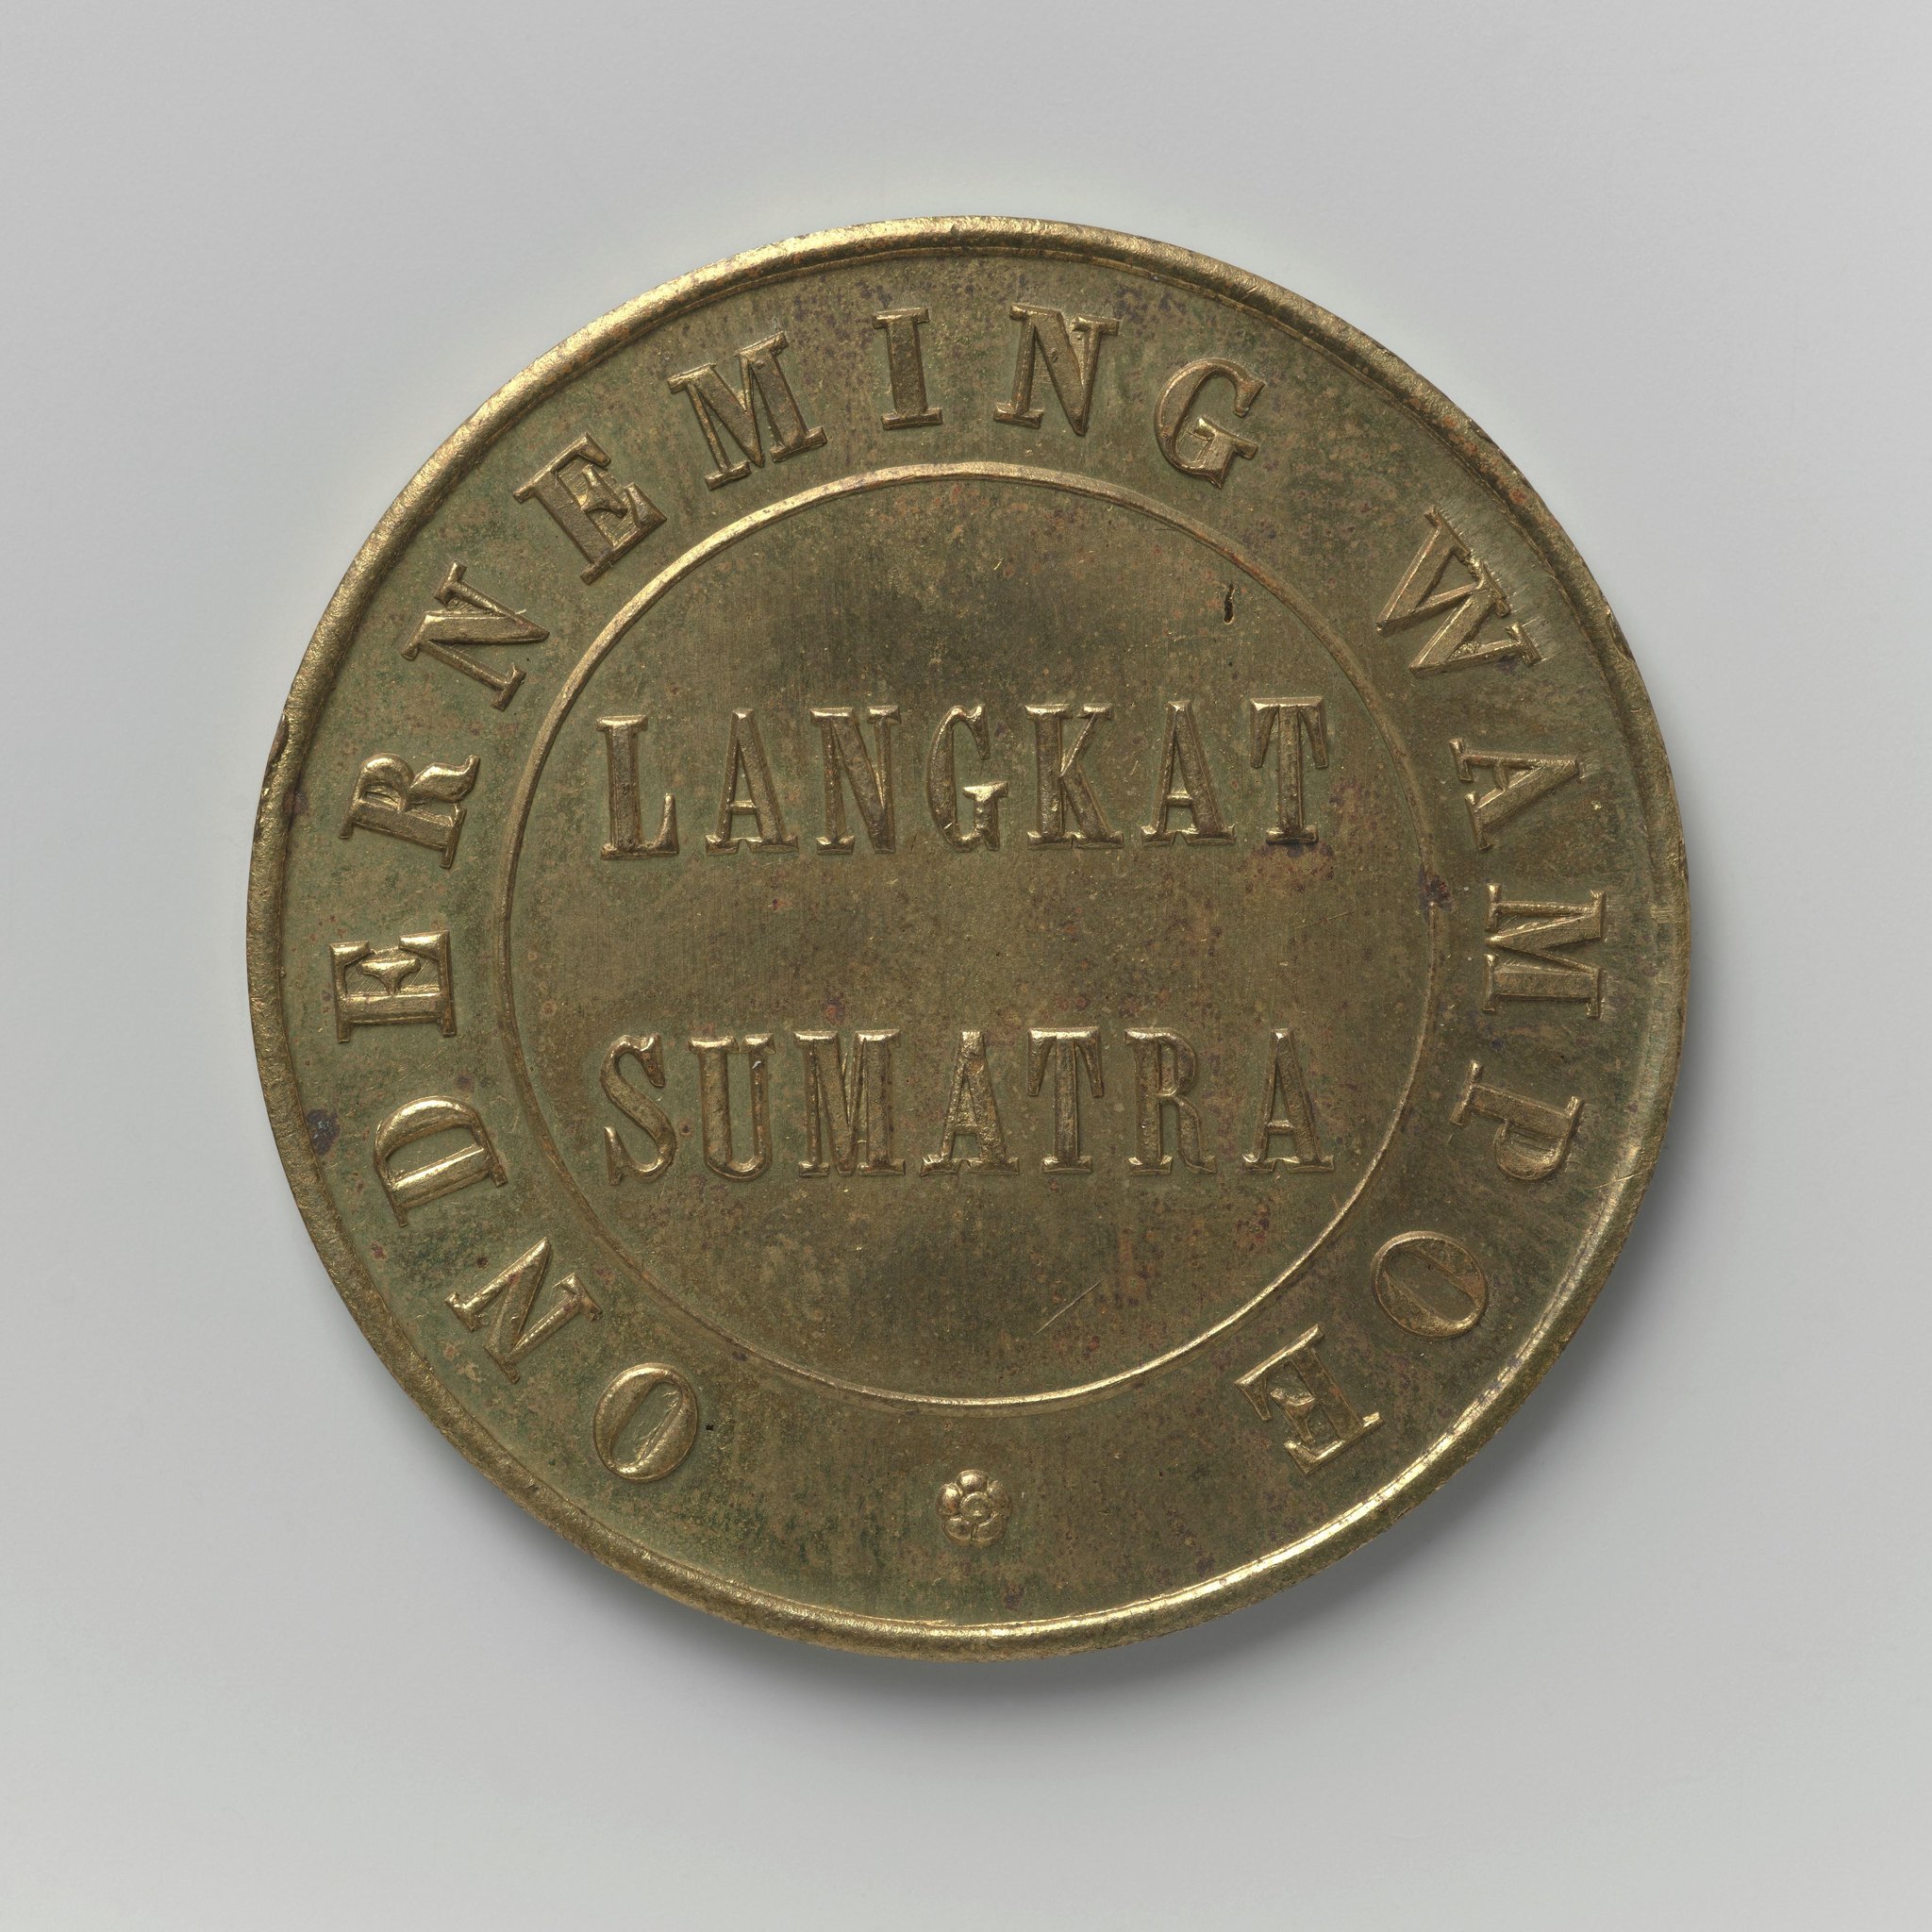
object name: monetary token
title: Plantage Wampoe, Langkat, Sumatra, dollar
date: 1888-1892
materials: nickel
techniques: striking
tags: langkat, plantage wampoe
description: Nikkelen partuculiere munt. Plantage-geld. Voorzijde: waarde-aanduiding.In omschrift waarde-aanduiding in het Nederlands en Chinese tekens. Keerzijde: tweeregelig opschrift, waaromheen naam van de plantage. Gladde rand.